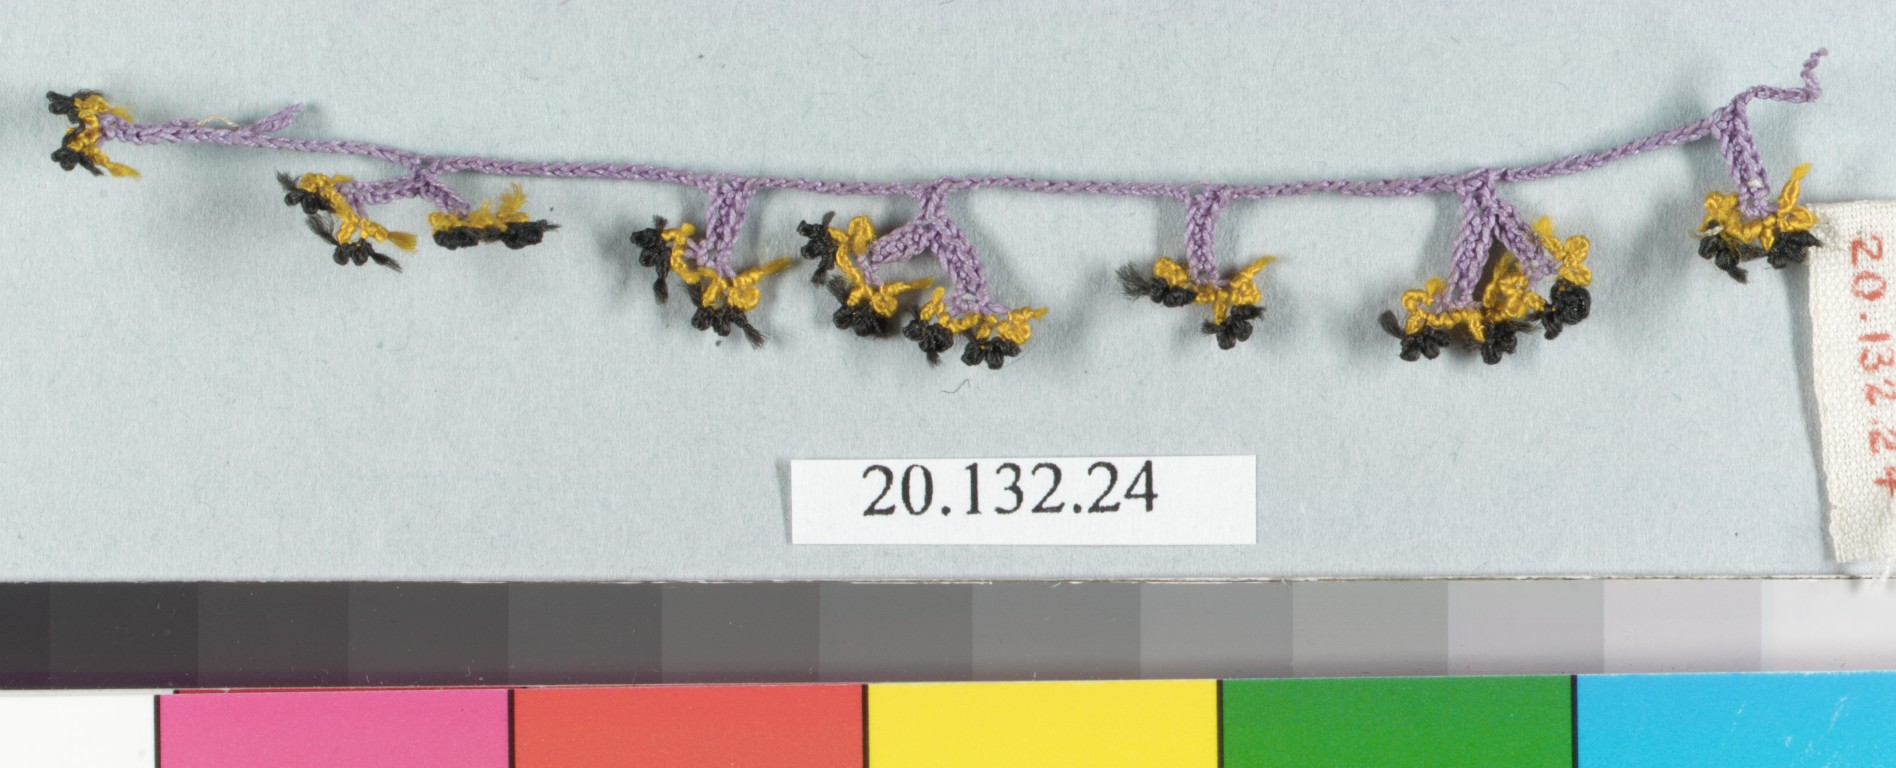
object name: oyah bibilia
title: Oyah (Bibilia)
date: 1801-1900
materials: silk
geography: turkey